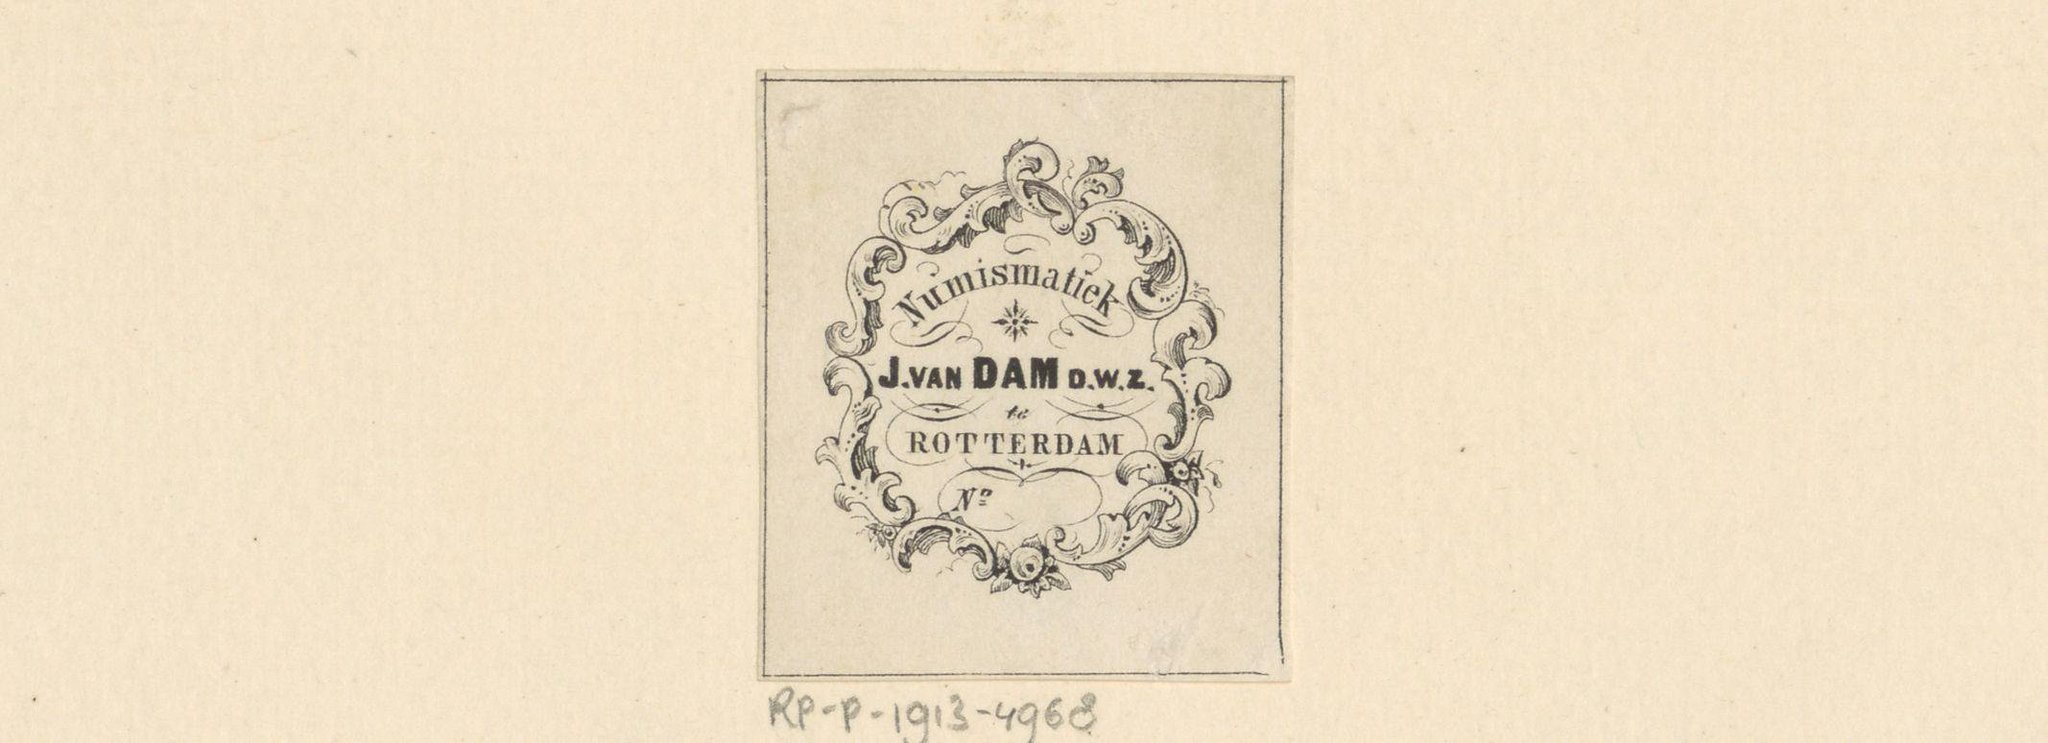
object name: bookplate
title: Naamsetiket van J. van Dam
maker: Anonymous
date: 1850-1913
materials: paper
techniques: engraving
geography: rotterdam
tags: ornament ~ festoon, garland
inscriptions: collector's mark: Lugt 2760, collector's mark: Lugt 2233